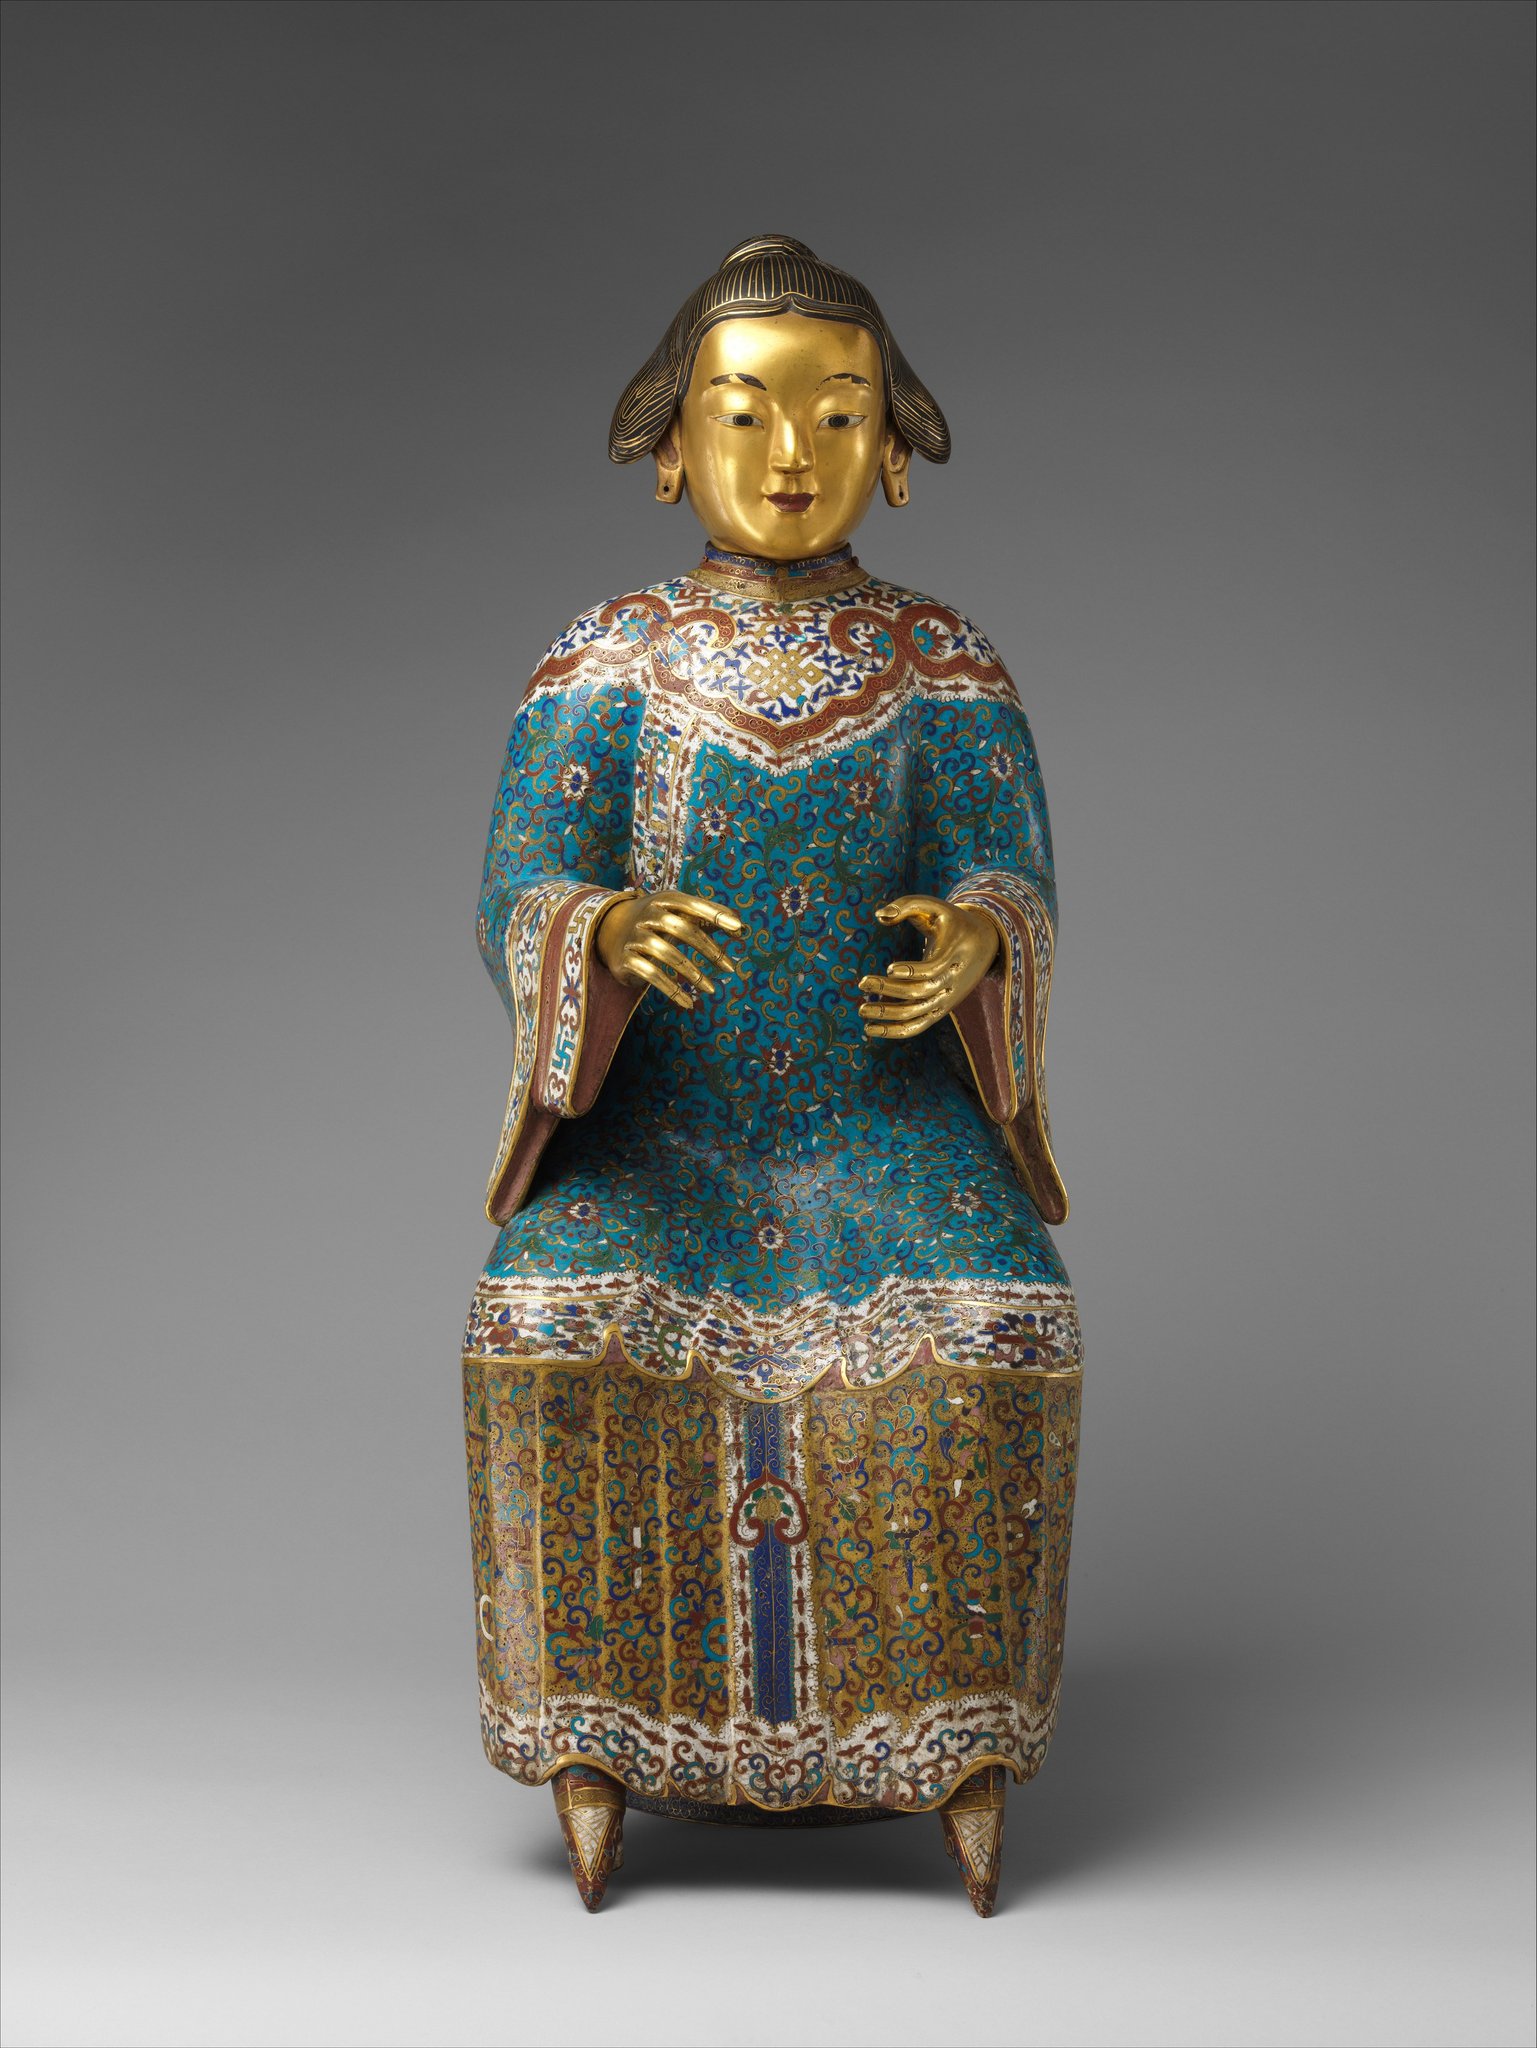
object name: figure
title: Seated Figure (one of a pair)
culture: chinese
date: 1736-1795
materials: enamel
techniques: enamel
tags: women